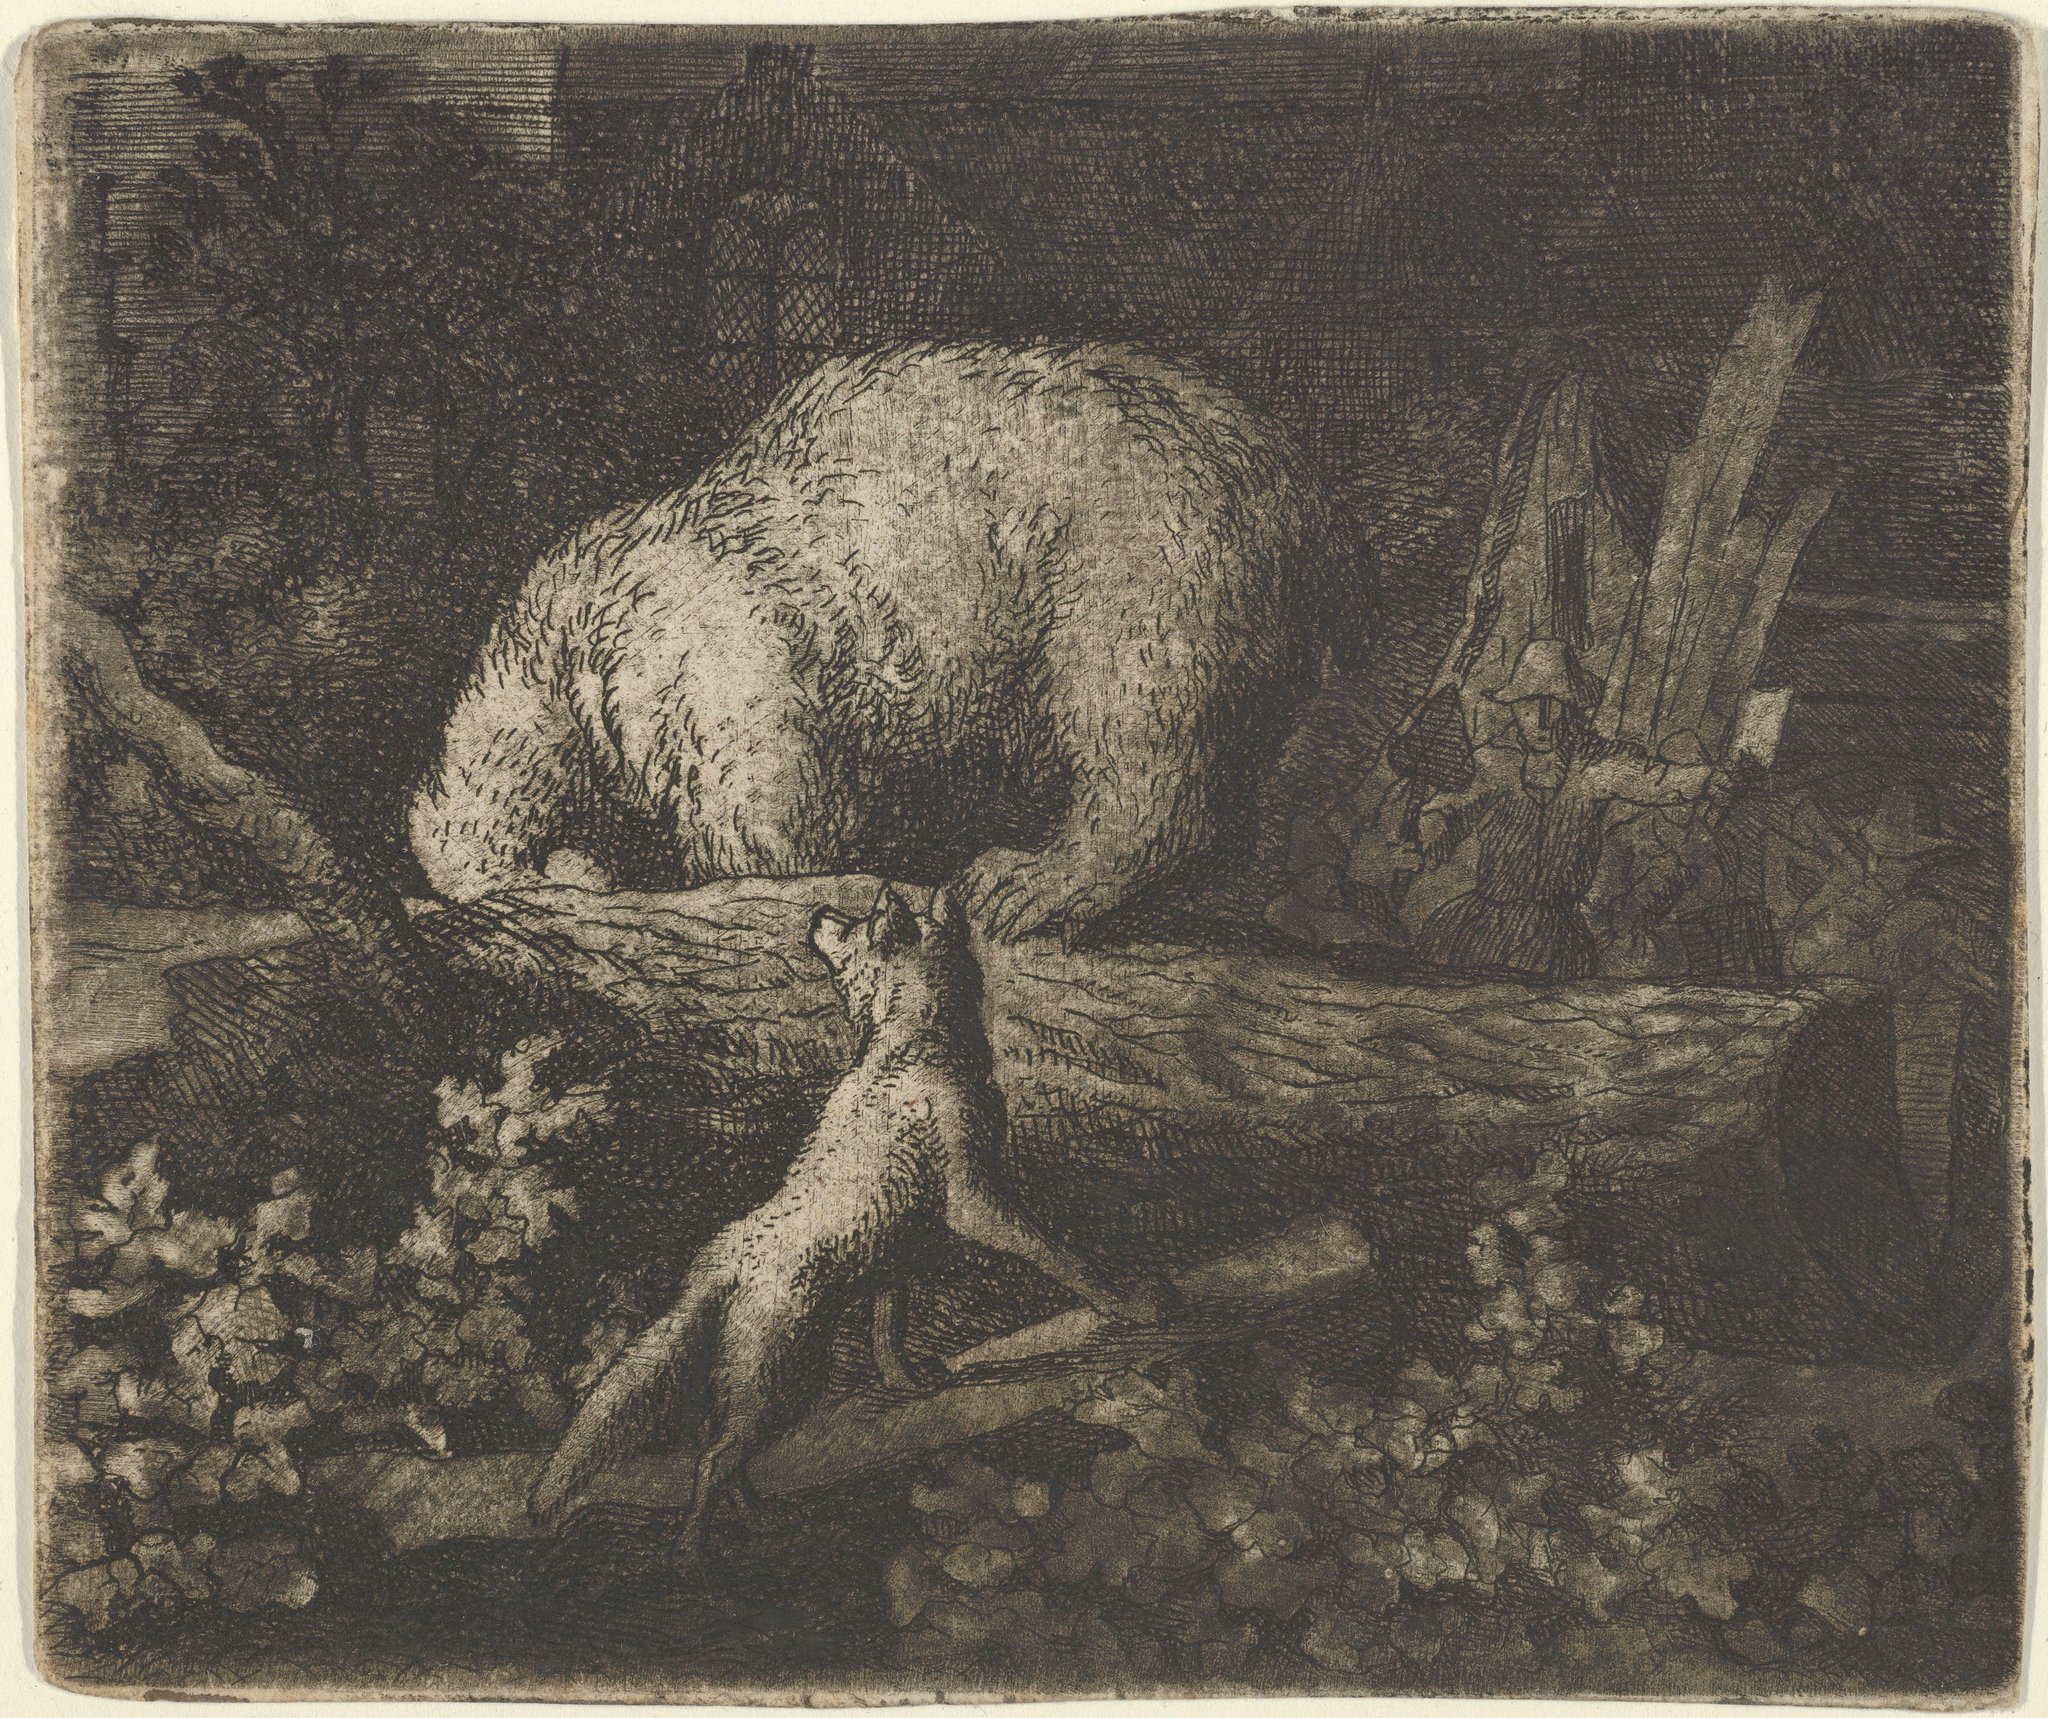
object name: print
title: The Bear with His Snout and Forepaws Caught in the Trunk of a Tree from Hendrick van Alcmar's Renard The Fox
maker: allart van everdingen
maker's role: artist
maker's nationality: dutch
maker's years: 1621-1675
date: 1634-1666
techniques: mezzotint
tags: bears,foxes